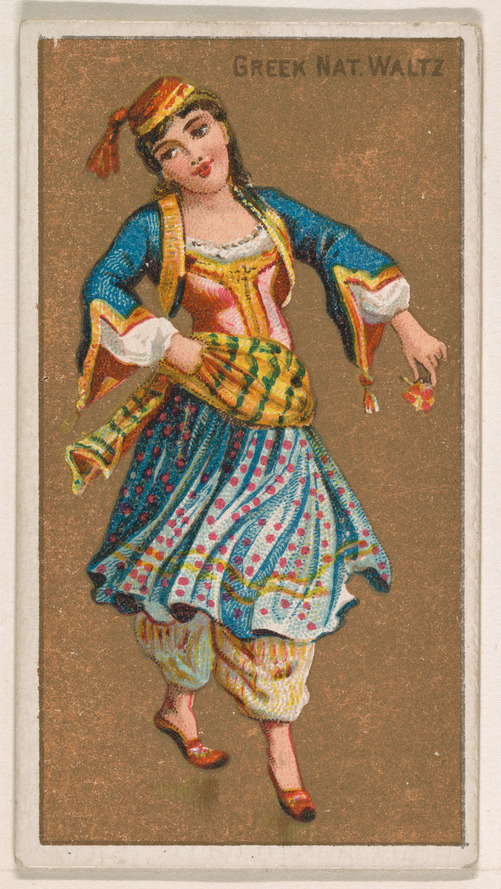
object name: print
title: Greek National Waltz, from National Dances (N225, Type 1) issued by Kinney Bros.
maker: kinney brothers tobacco company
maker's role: publisher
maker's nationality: american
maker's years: 1869-2011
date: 1889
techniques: color lithograph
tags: women,dancing